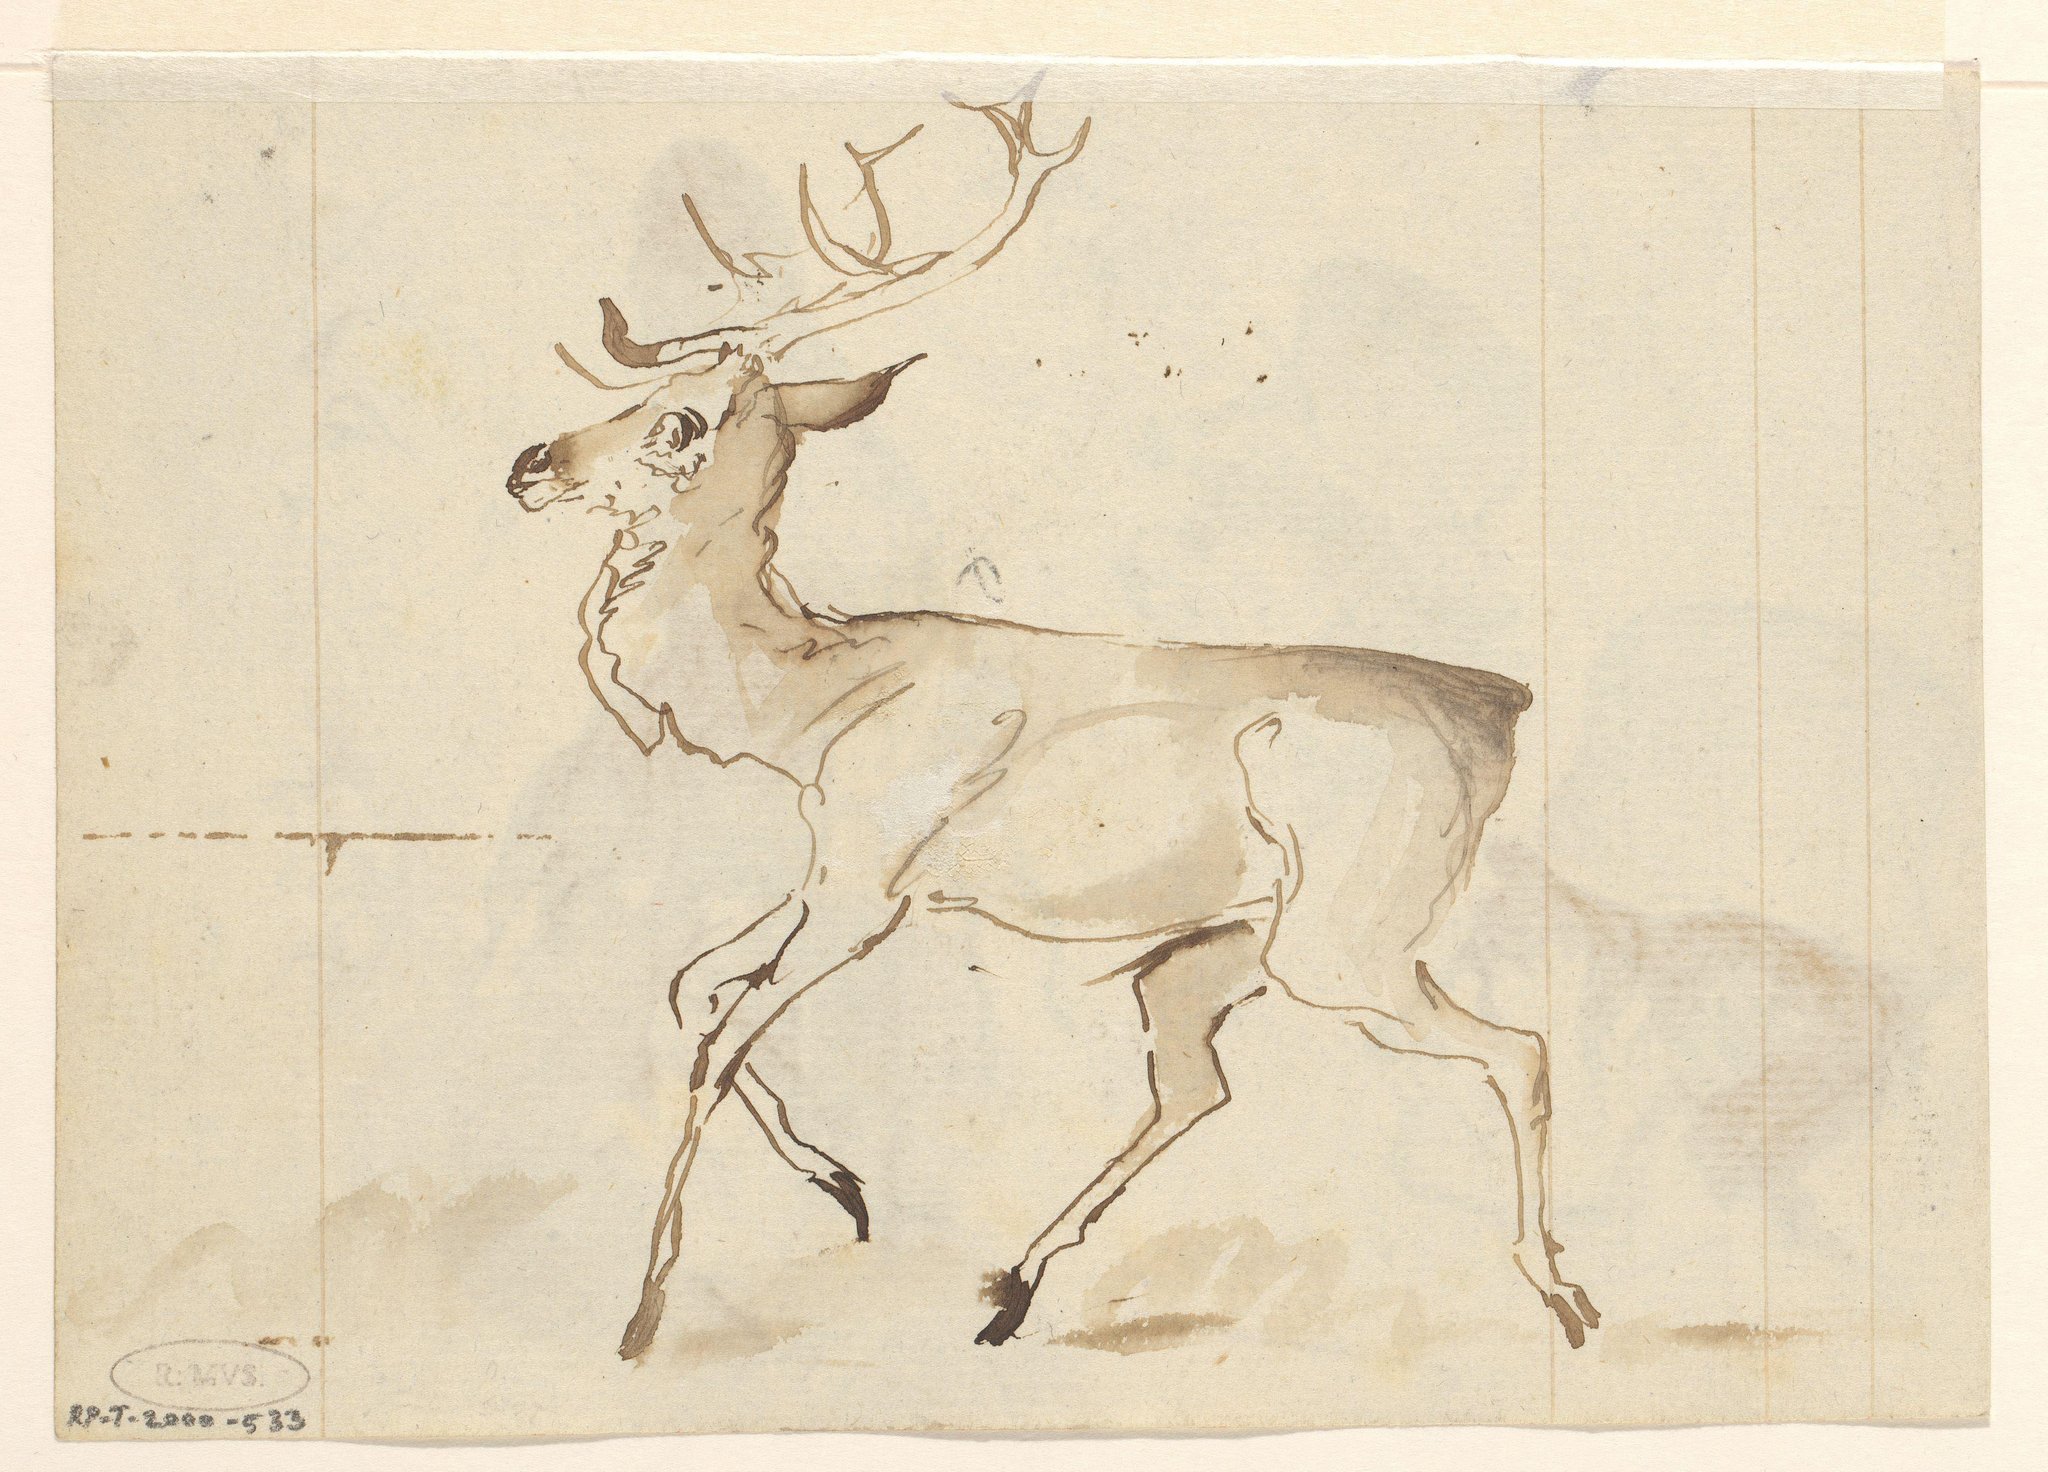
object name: drawing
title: Hert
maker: johannes tavenraat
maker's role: draughtsman, painter, print maker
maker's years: 1809-1881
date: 1840-1880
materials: ink, paper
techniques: brush, pen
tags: hoofed animals: deer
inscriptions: collector's mark: Lugt 2228